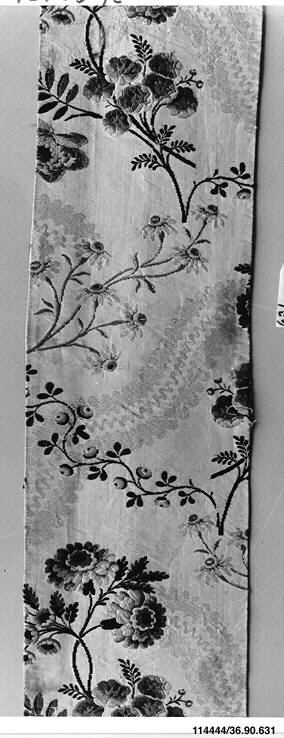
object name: piece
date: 1750-1760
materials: silk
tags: flowers